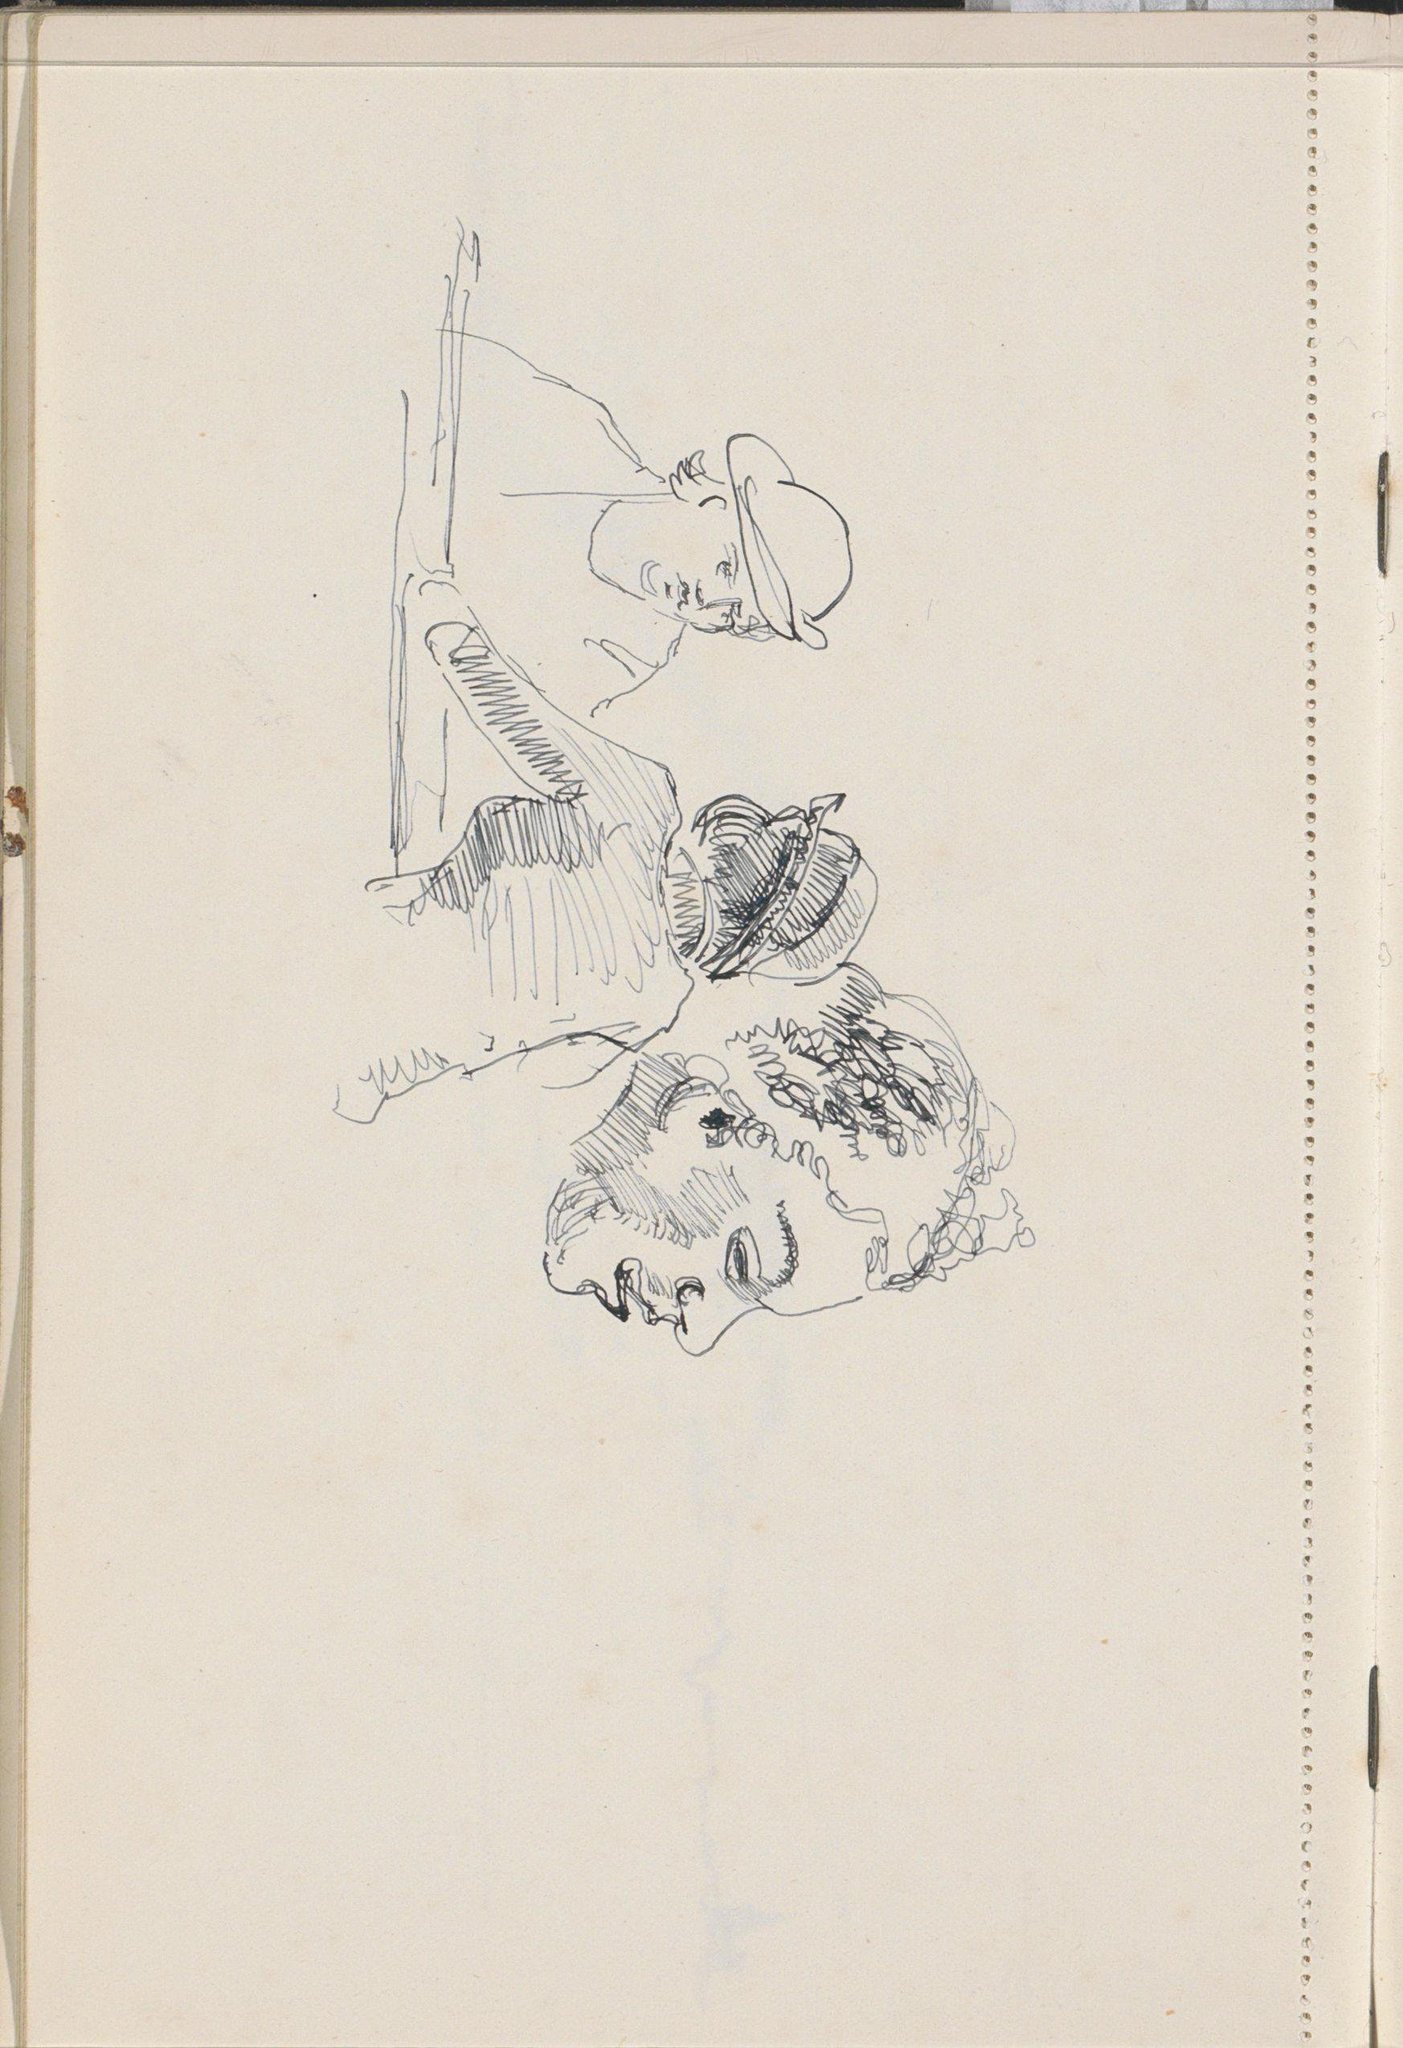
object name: sketchbook leaf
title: Man en vrouw aan een tafel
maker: cornelis vreedenburgh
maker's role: draughtsman, print maker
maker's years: 1880-1946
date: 1935-1936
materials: ink, paper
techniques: pen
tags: head (human), sitting figure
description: De man en vrouw zitten tegenover elkaar aan een tafel. Tevens een studie van een mannenkop. Blad 35 verso uit een schetsboek met 73 bladen.